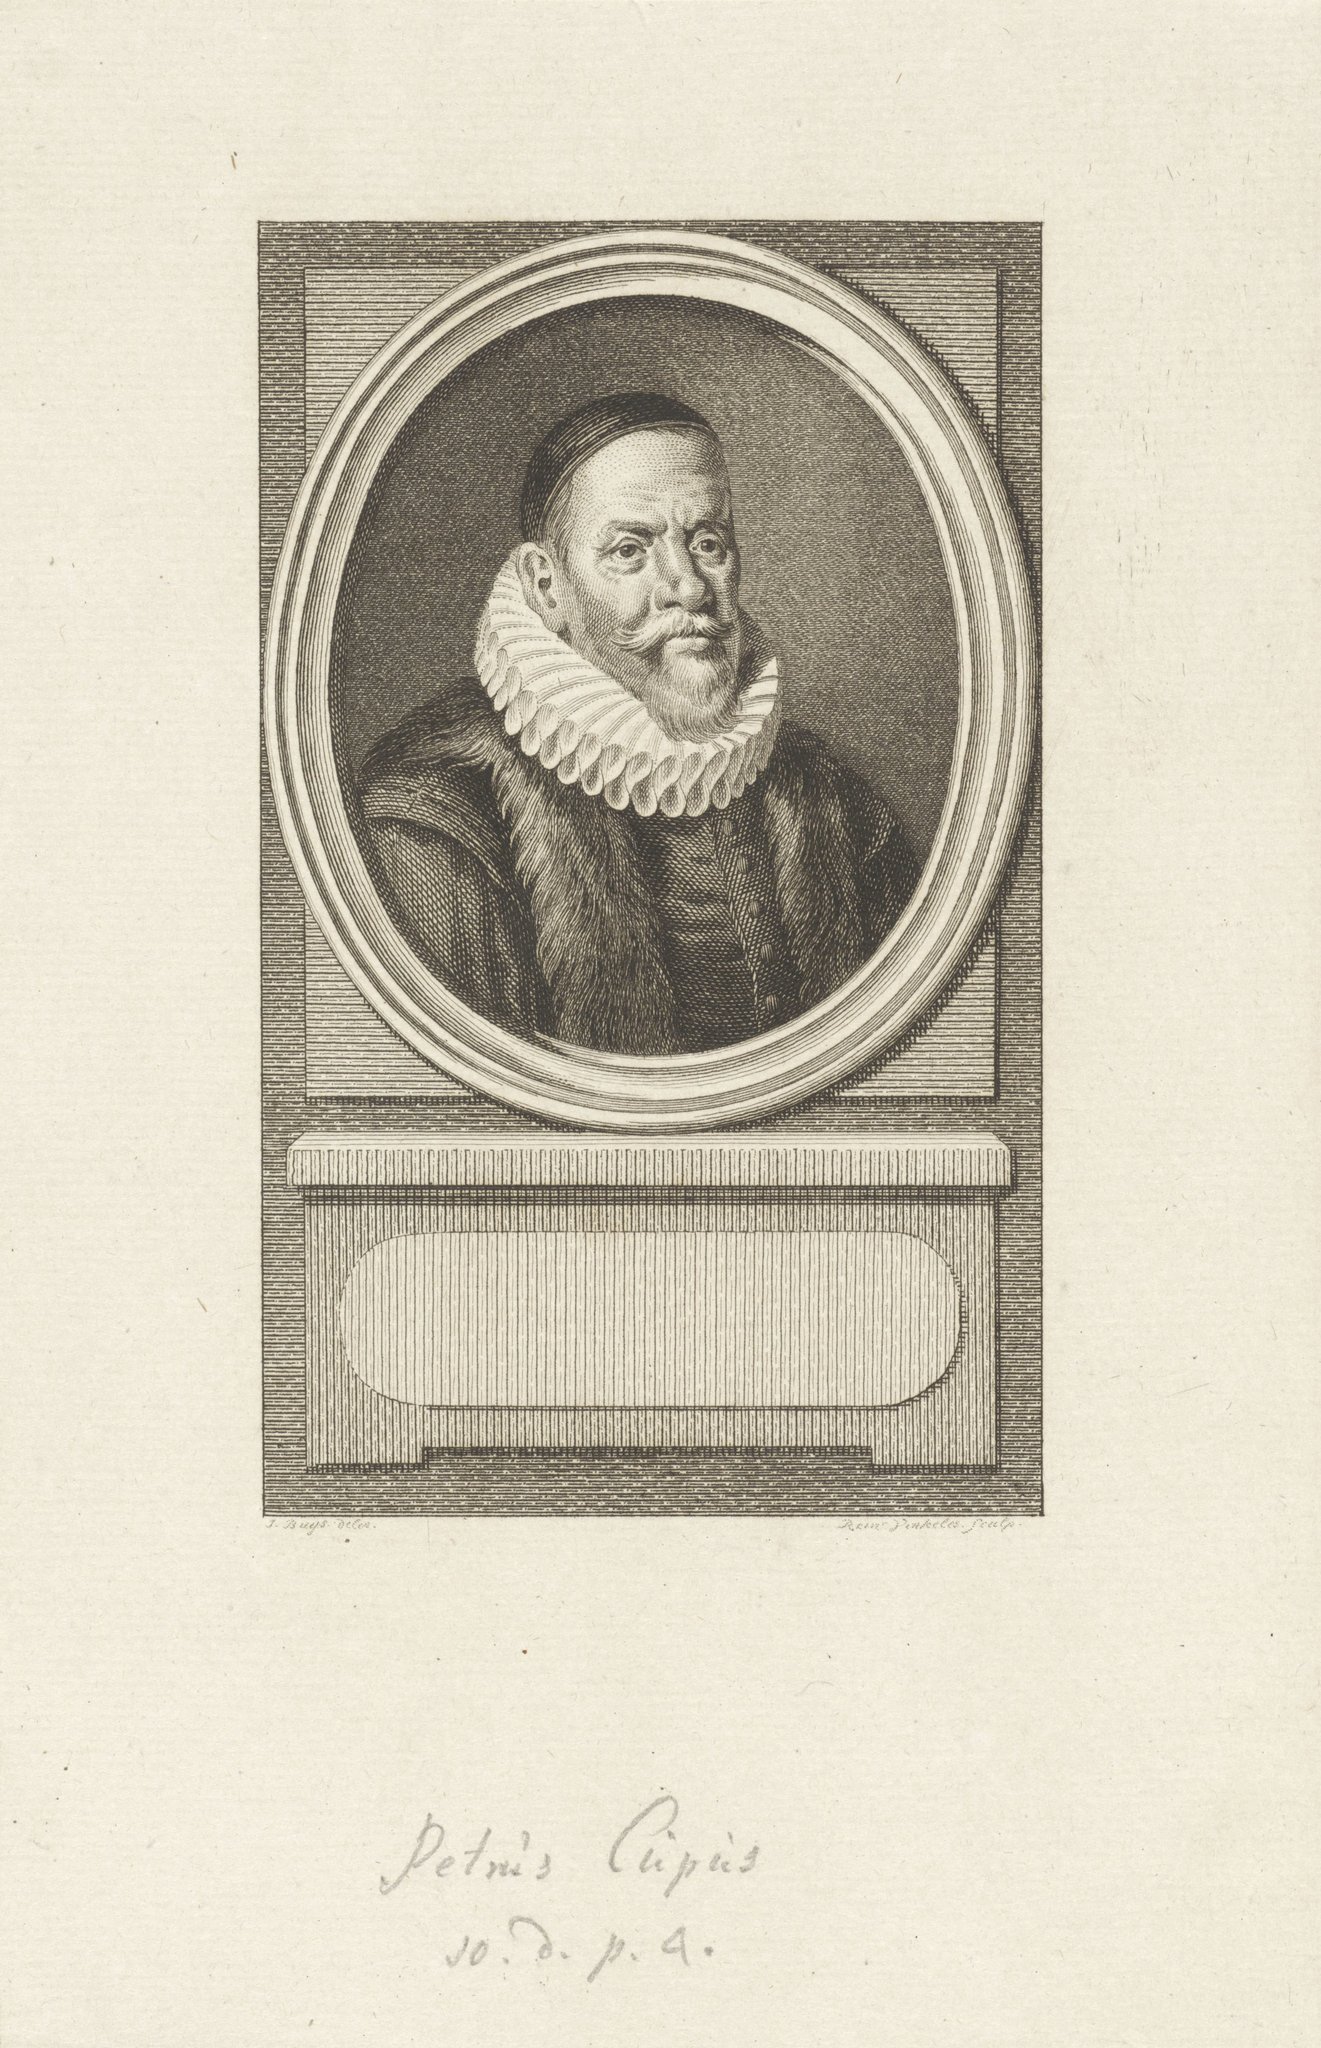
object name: print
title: Portret van Petrus Cupus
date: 1788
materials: paper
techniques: engraving, etching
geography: amsterdam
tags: rotterdam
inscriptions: collector's mark: Lugt 240, inscription: ‘Petrus Cupus 10 d. p. 4.’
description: Latere staat prent gebruikt als boekillustratie in: Kok, Jacobus. Vaderlandsch woordenboek : met kaarten, plaaten en pourtraitten. Amsterdam: Johannes Allart, 1785-1796. Deel X.